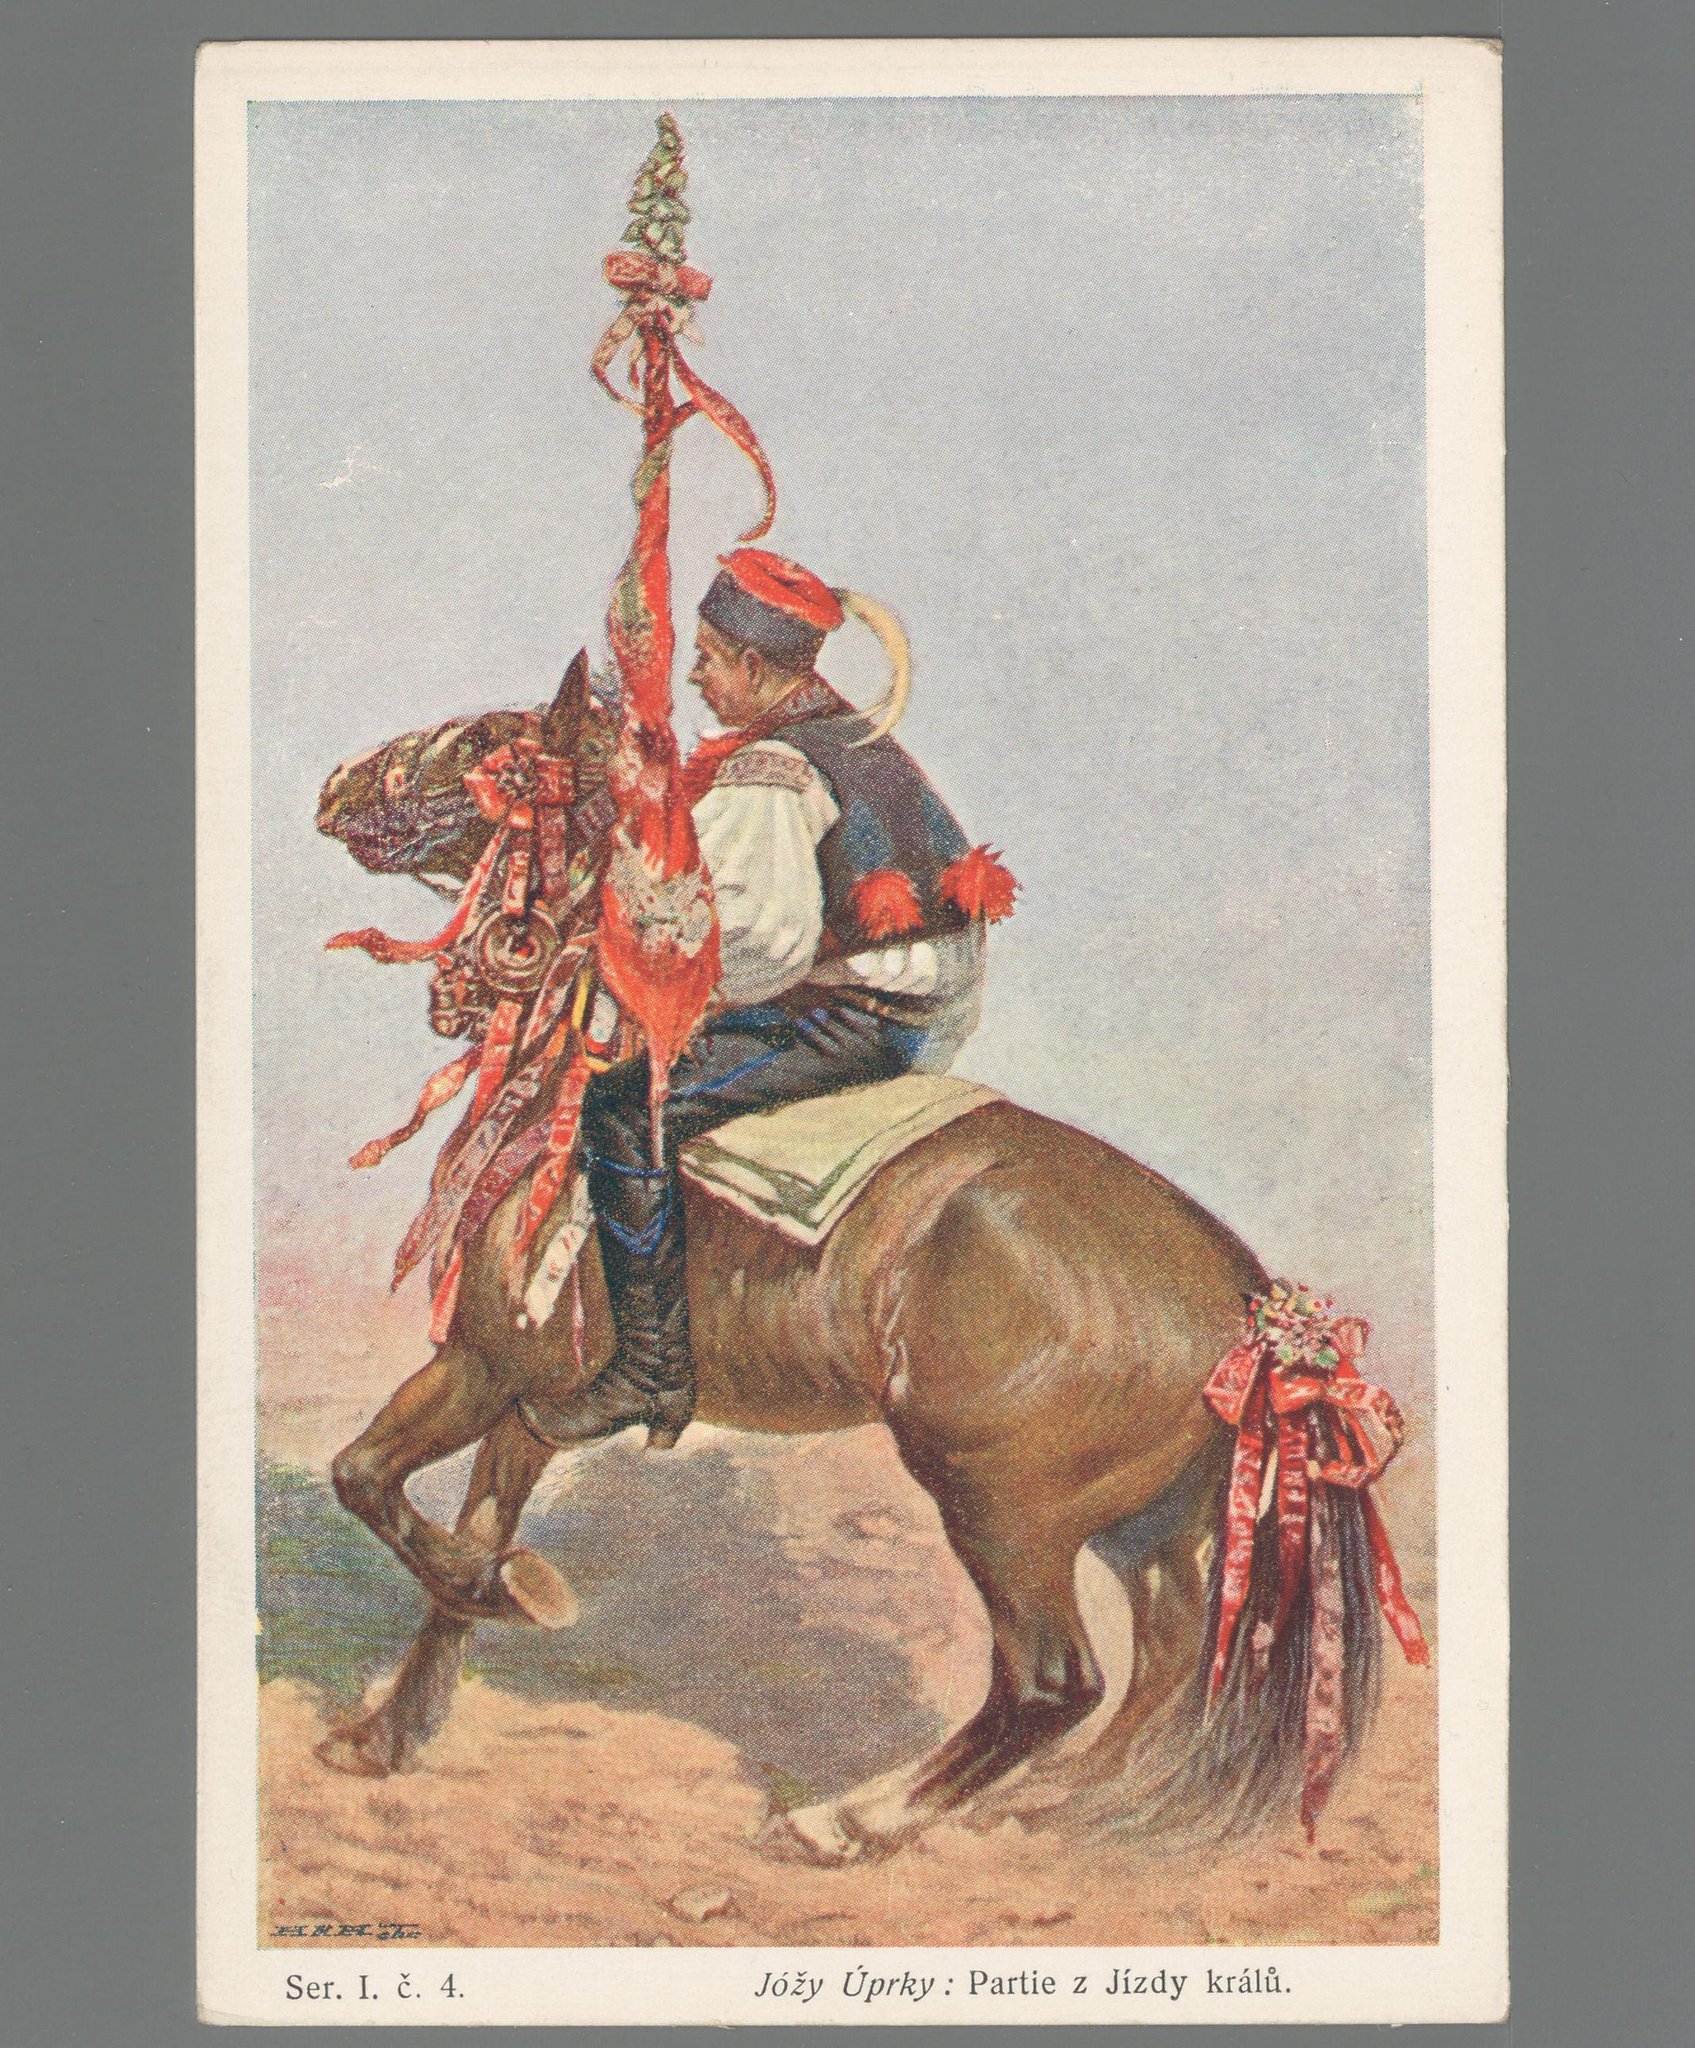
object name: ansichtkaart, prentbriefkaart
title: Józy Úprky: Partie z Jízdy králu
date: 1906-1930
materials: cardboard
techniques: color autotype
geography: olomouc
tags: riding a horse, ass, or mule; rider, horseman, prague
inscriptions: inscription: ‘H&M’